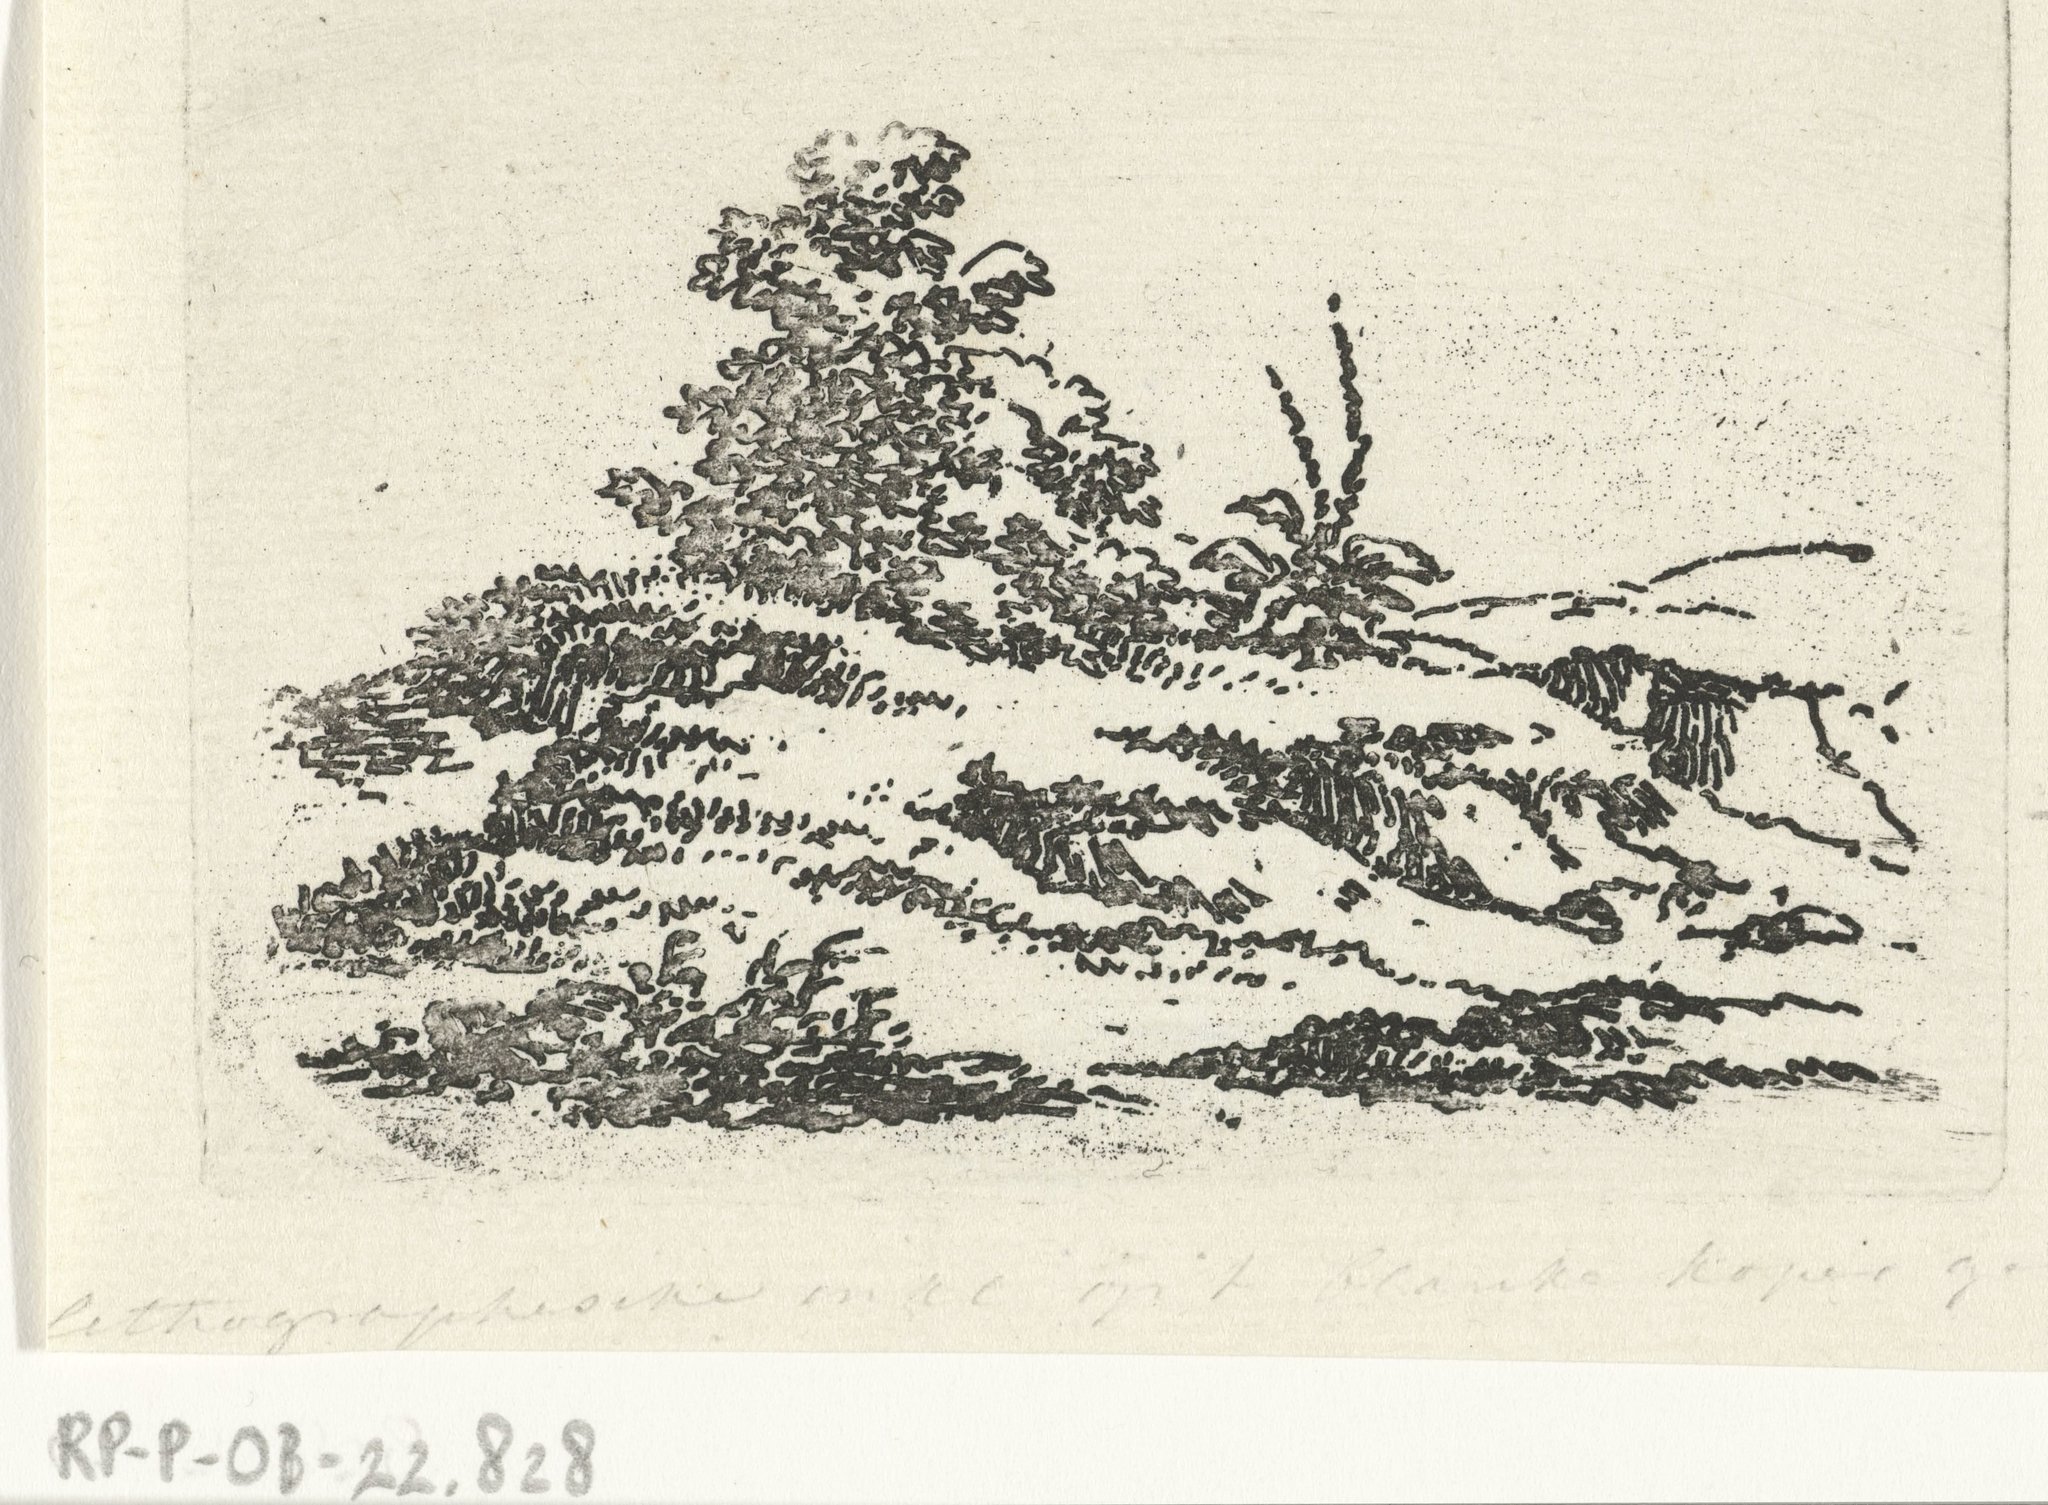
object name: print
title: Landschap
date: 1803-1842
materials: paper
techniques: etching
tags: landscapes in the temperate zone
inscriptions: collector's mark: Lugt 2228